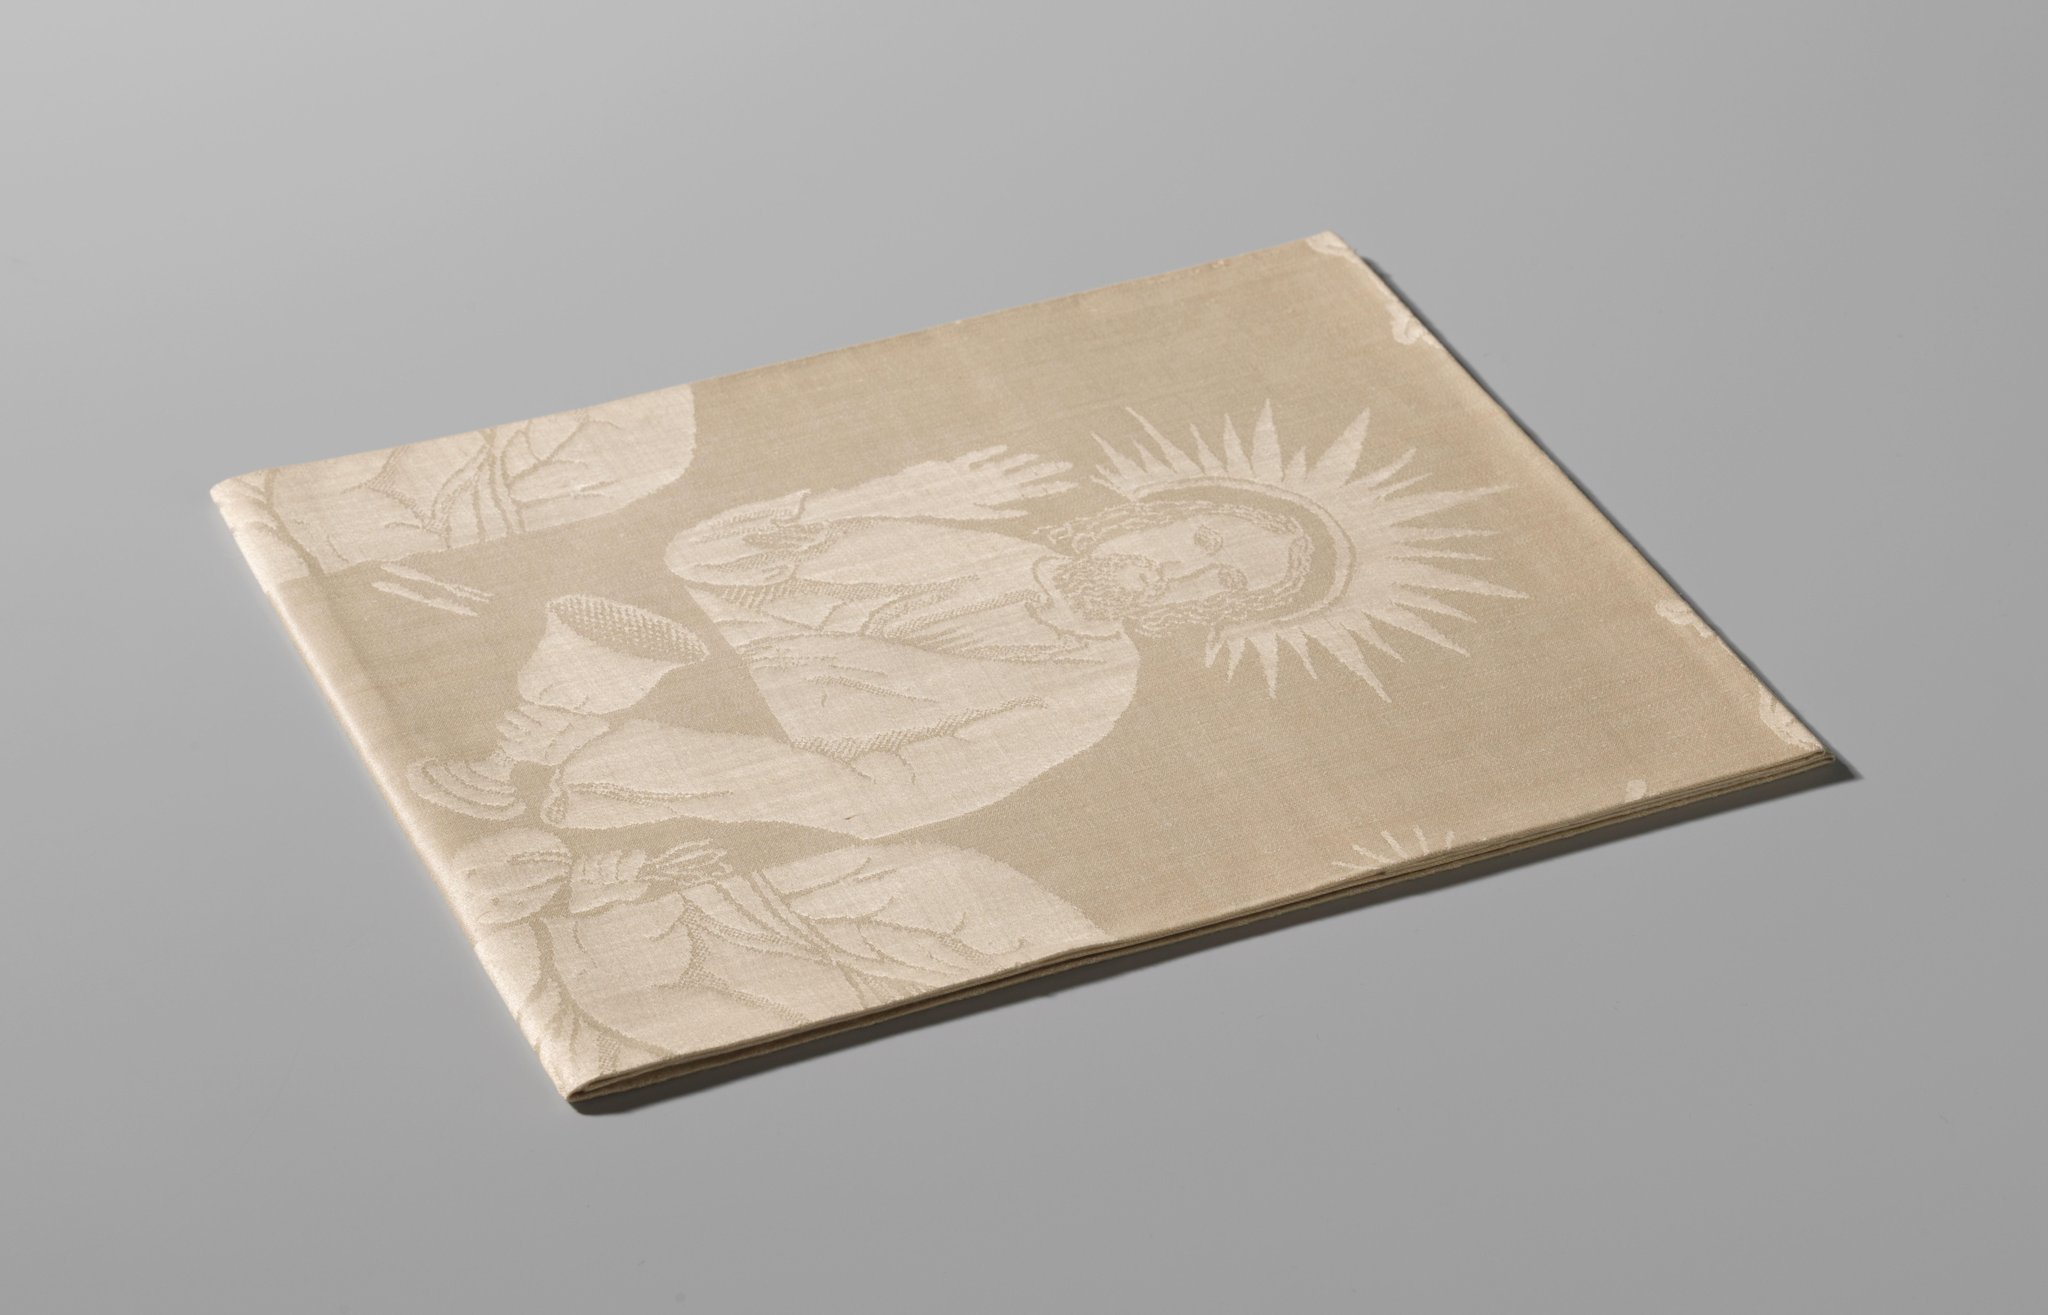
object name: napkin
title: Servet van wit linnendamast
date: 1859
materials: linen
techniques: damask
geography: borne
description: Wit linnen damasten servet met een voorstelling van het Laatste Avondmaal.